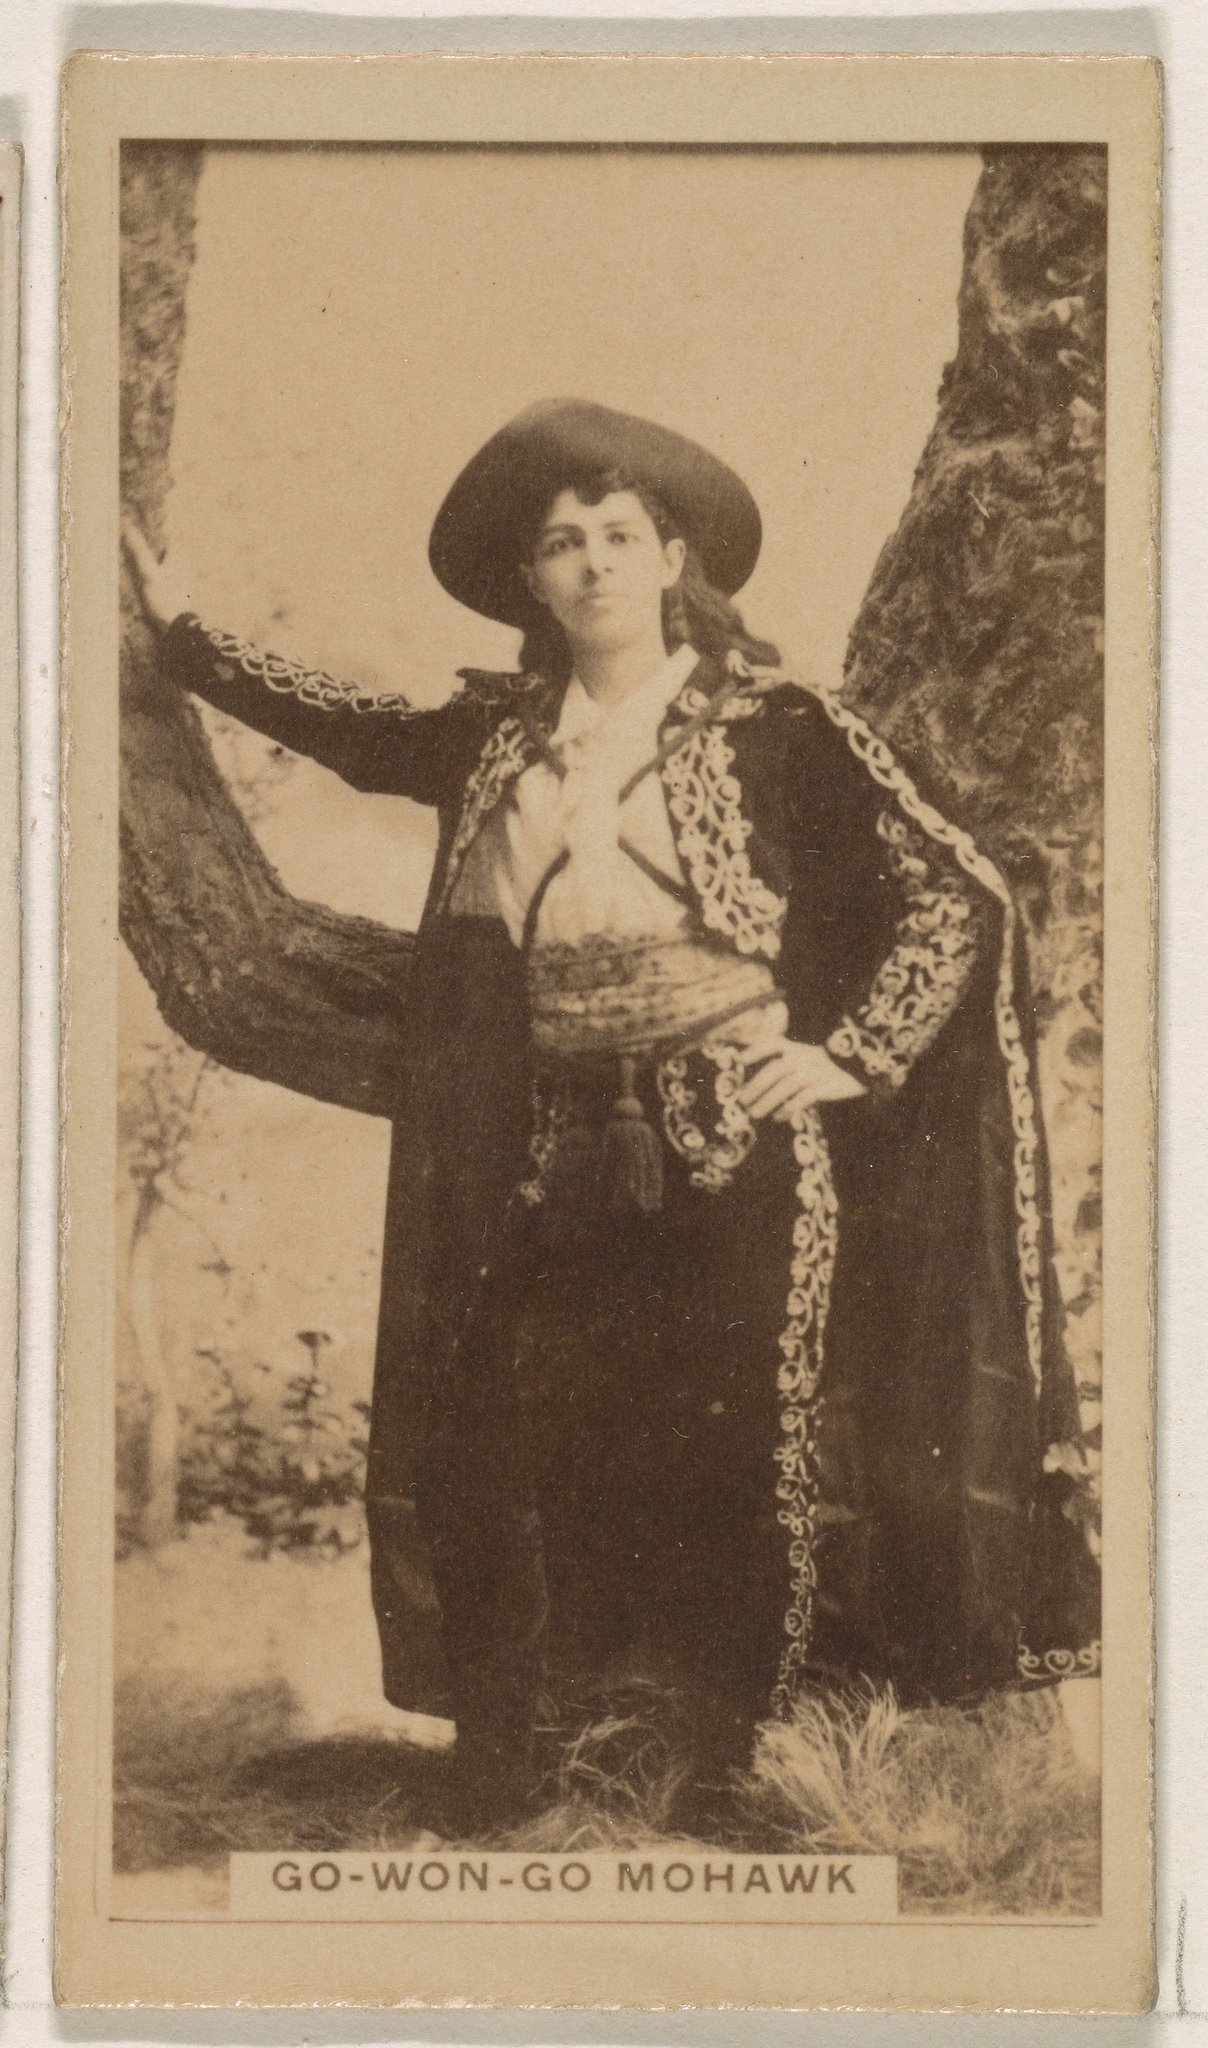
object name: photograph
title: Go-Won-Go Mohawk, from the Actresses series (N245) issued by Kinney Brothers to promote Sweet Caporal Cigarettes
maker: kinney brothers tobacco company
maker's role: publisher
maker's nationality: american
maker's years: 1869-2011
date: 1890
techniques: albumen silver print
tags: portraits,women,actresses